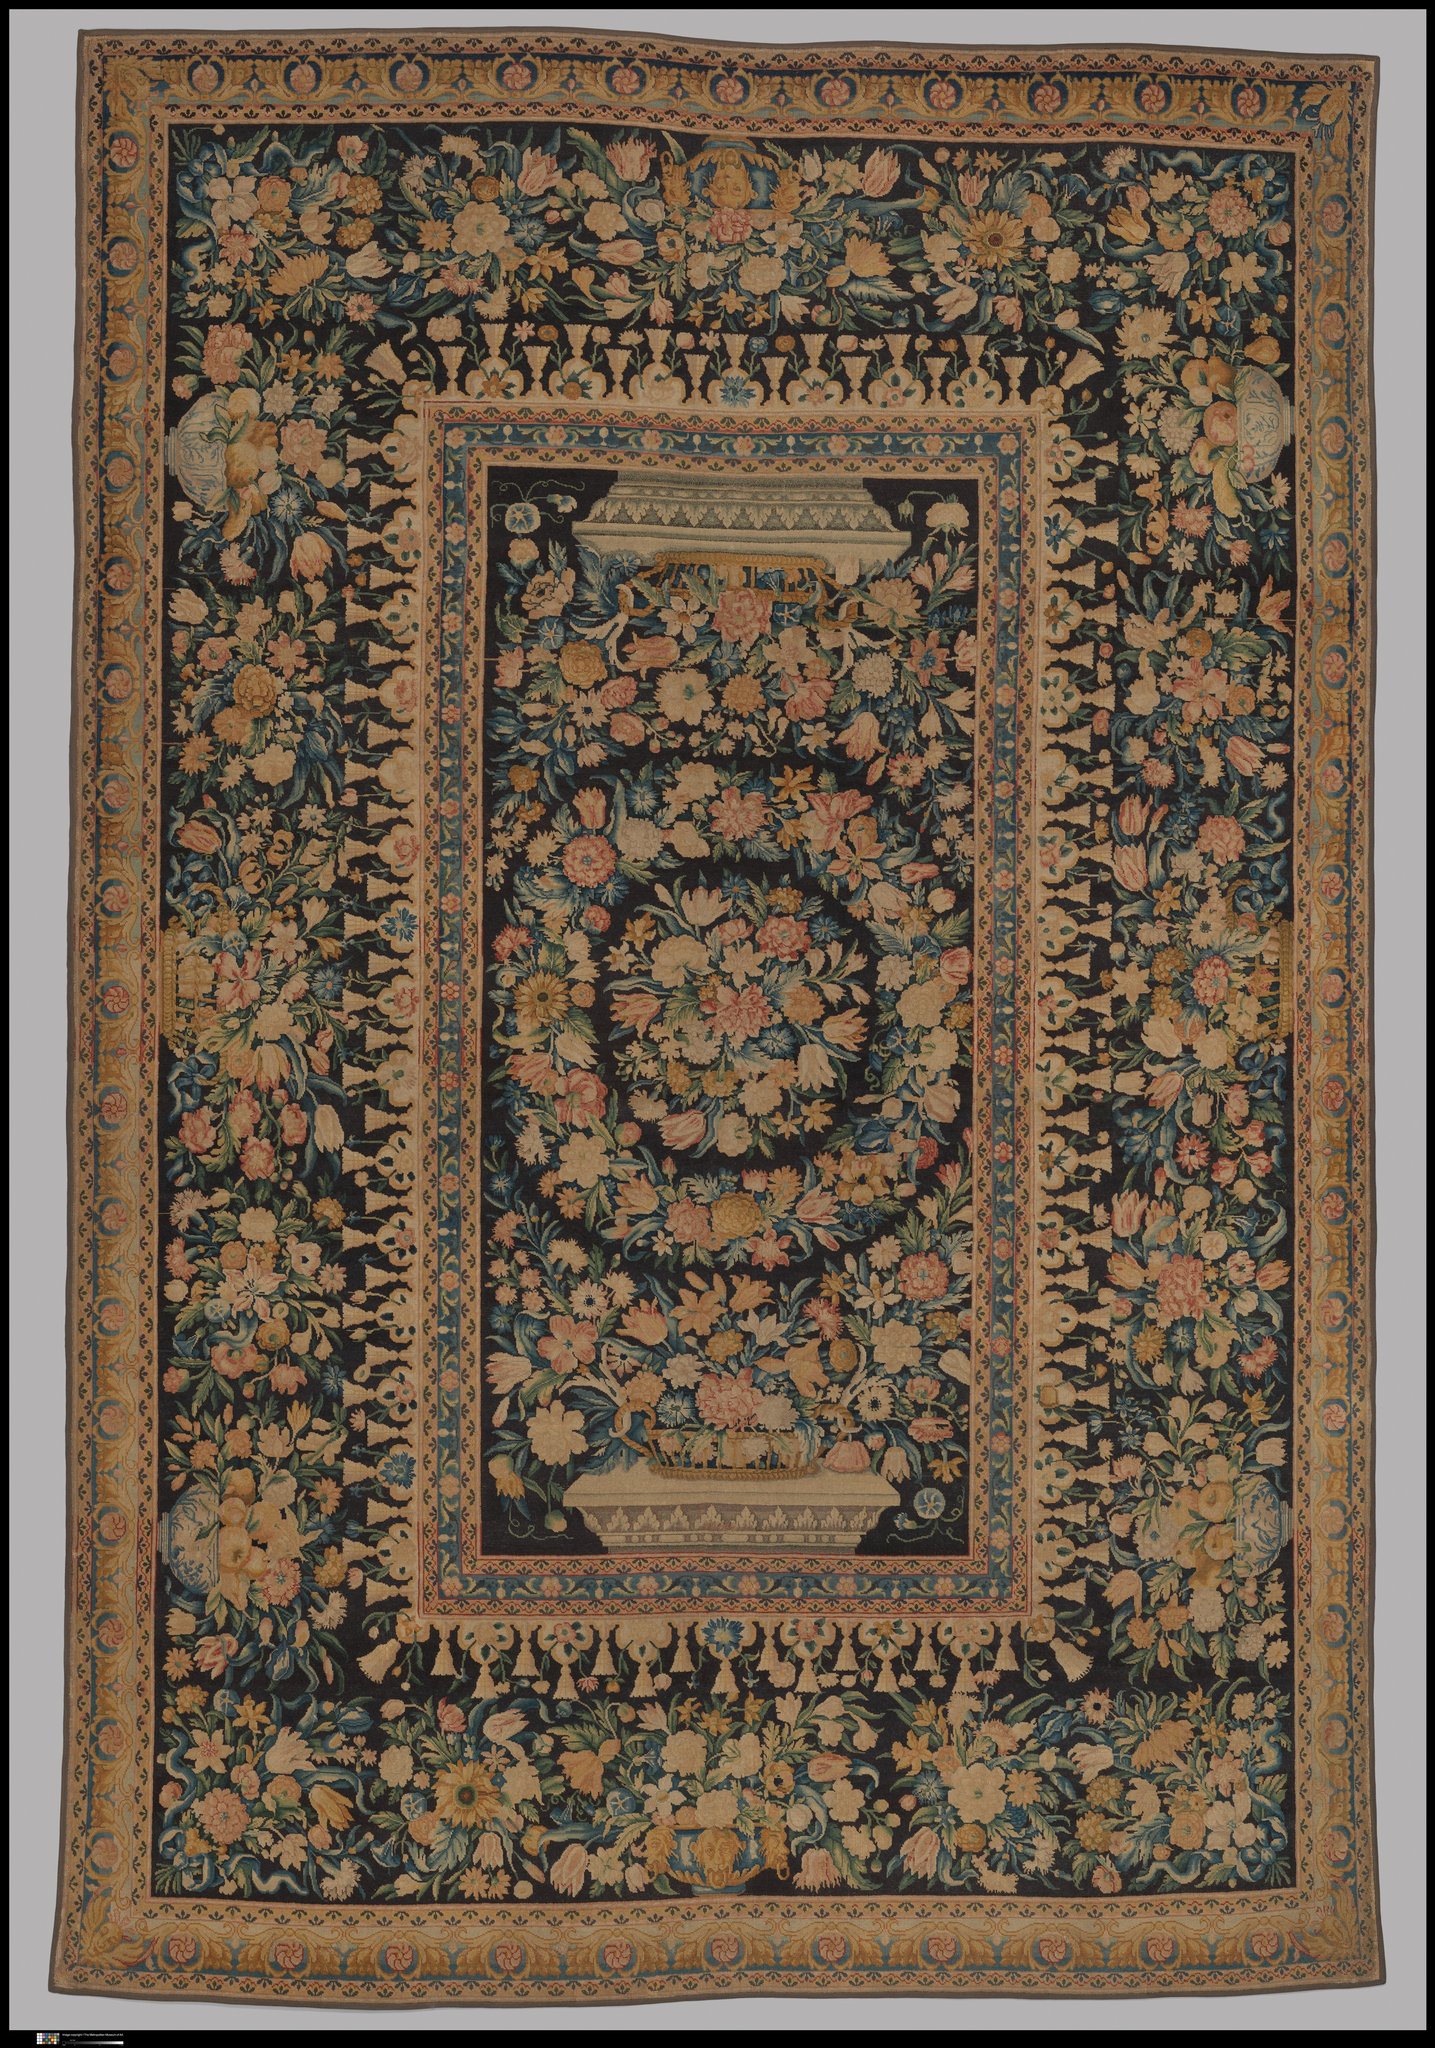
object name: carpet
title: Carpet (tapis)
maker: savonnerie manufactory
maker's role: manufactory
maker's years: 1626-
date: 1634-1666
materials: wool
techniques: cutting, weave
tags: flowers